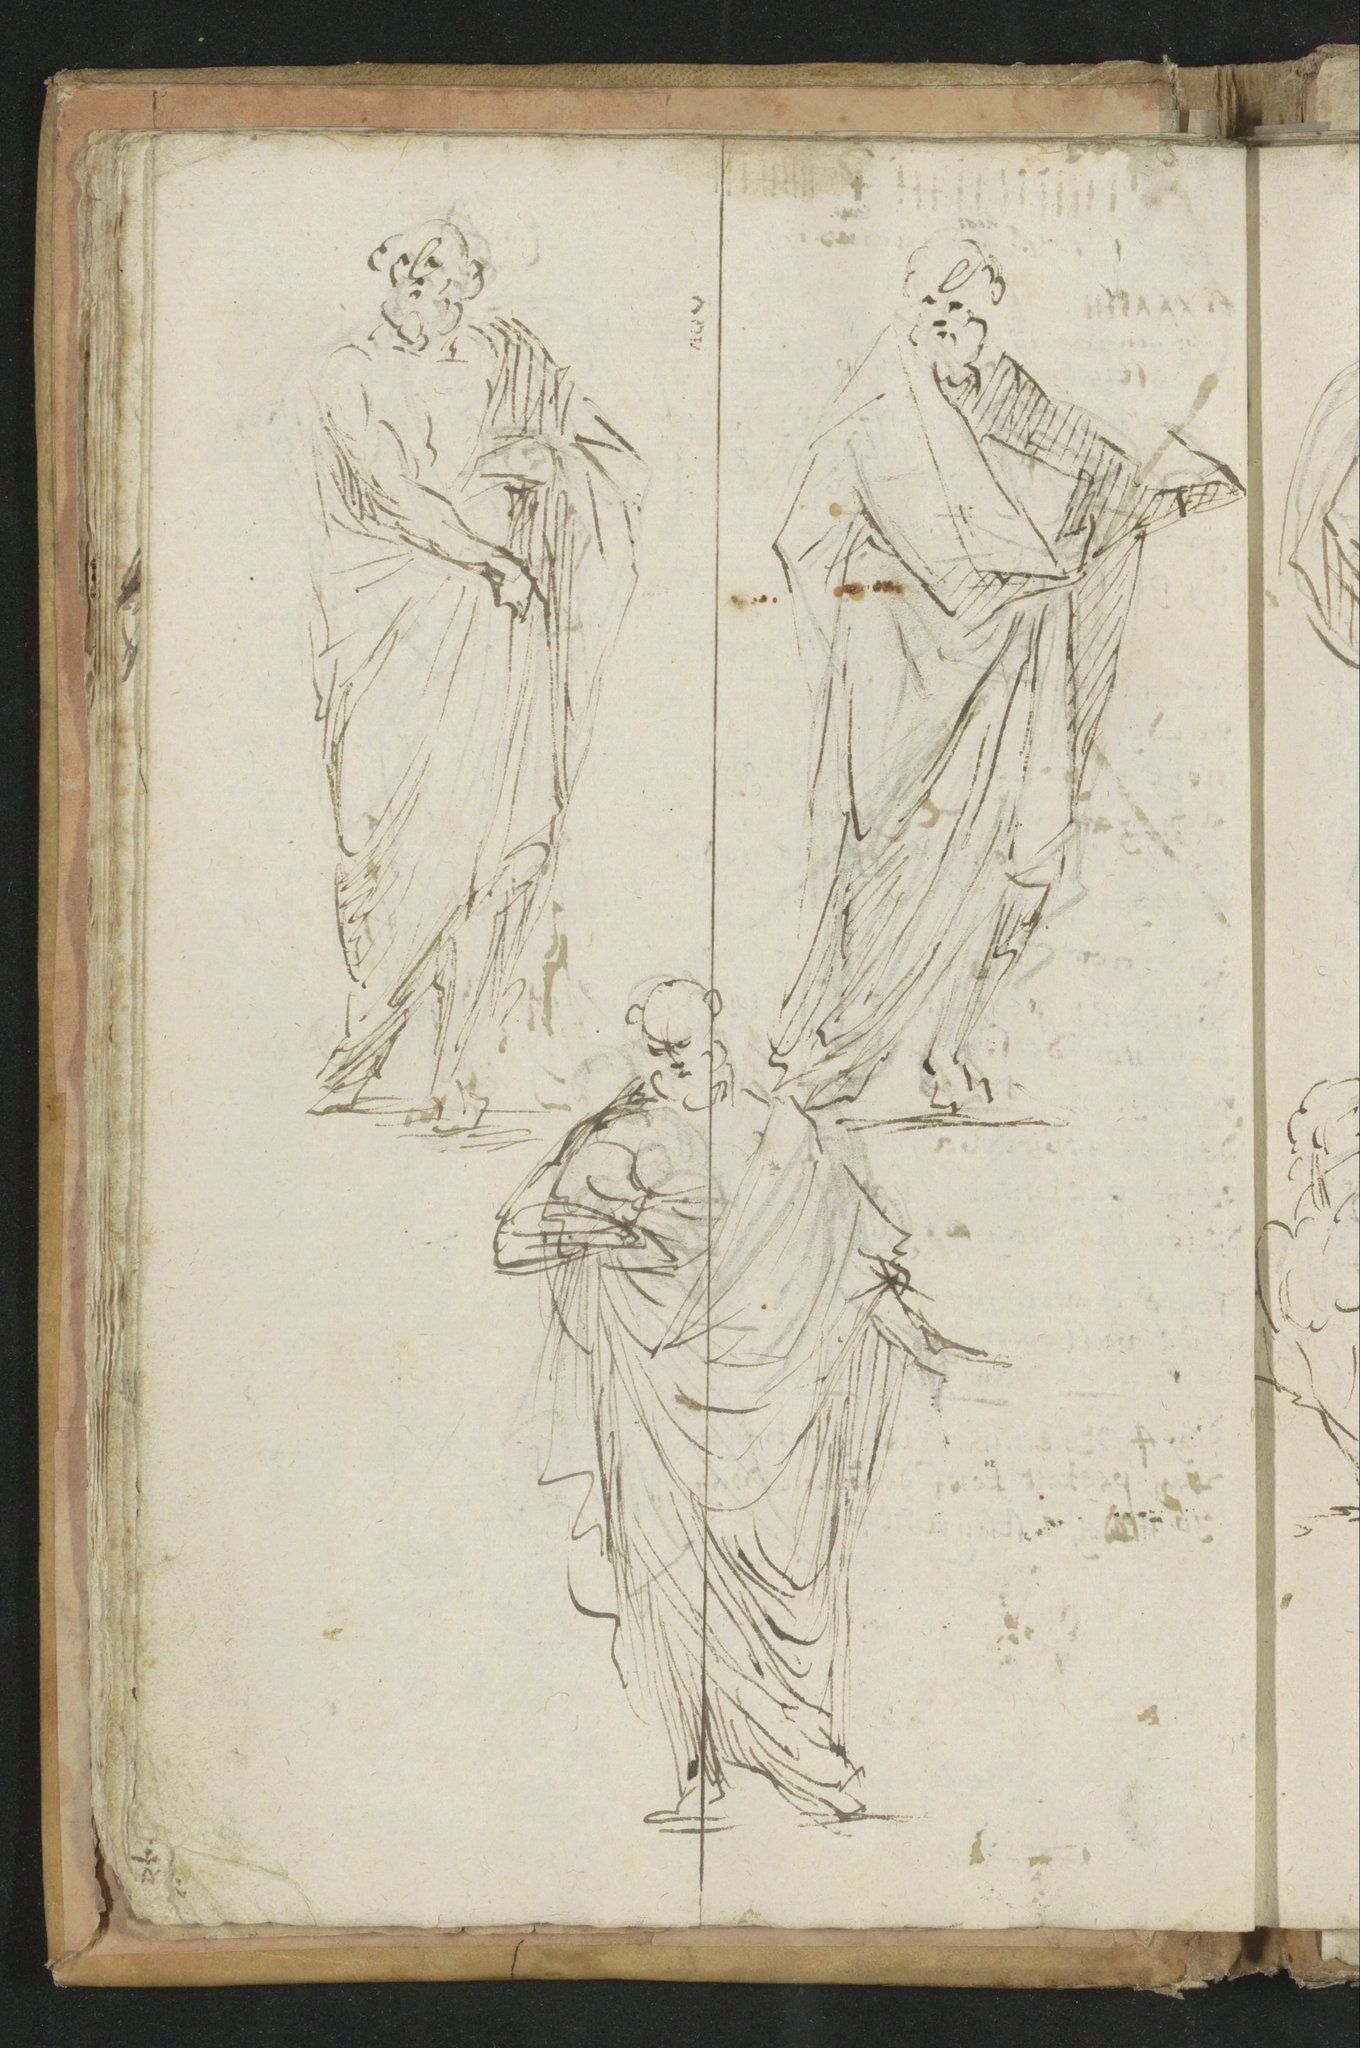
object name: sketchbook leaf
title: Drie staande mannen in toga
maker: Anonymous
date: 1658-1728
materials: ink, paper, pencil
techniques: pen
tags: standing figure, postures and gestures of arms and hands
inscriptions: annotation: ‘e e’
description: De mannen maken verschillende bewegingen met de armen. Blad 10 verso uit een schetsboek met 33 bladen.